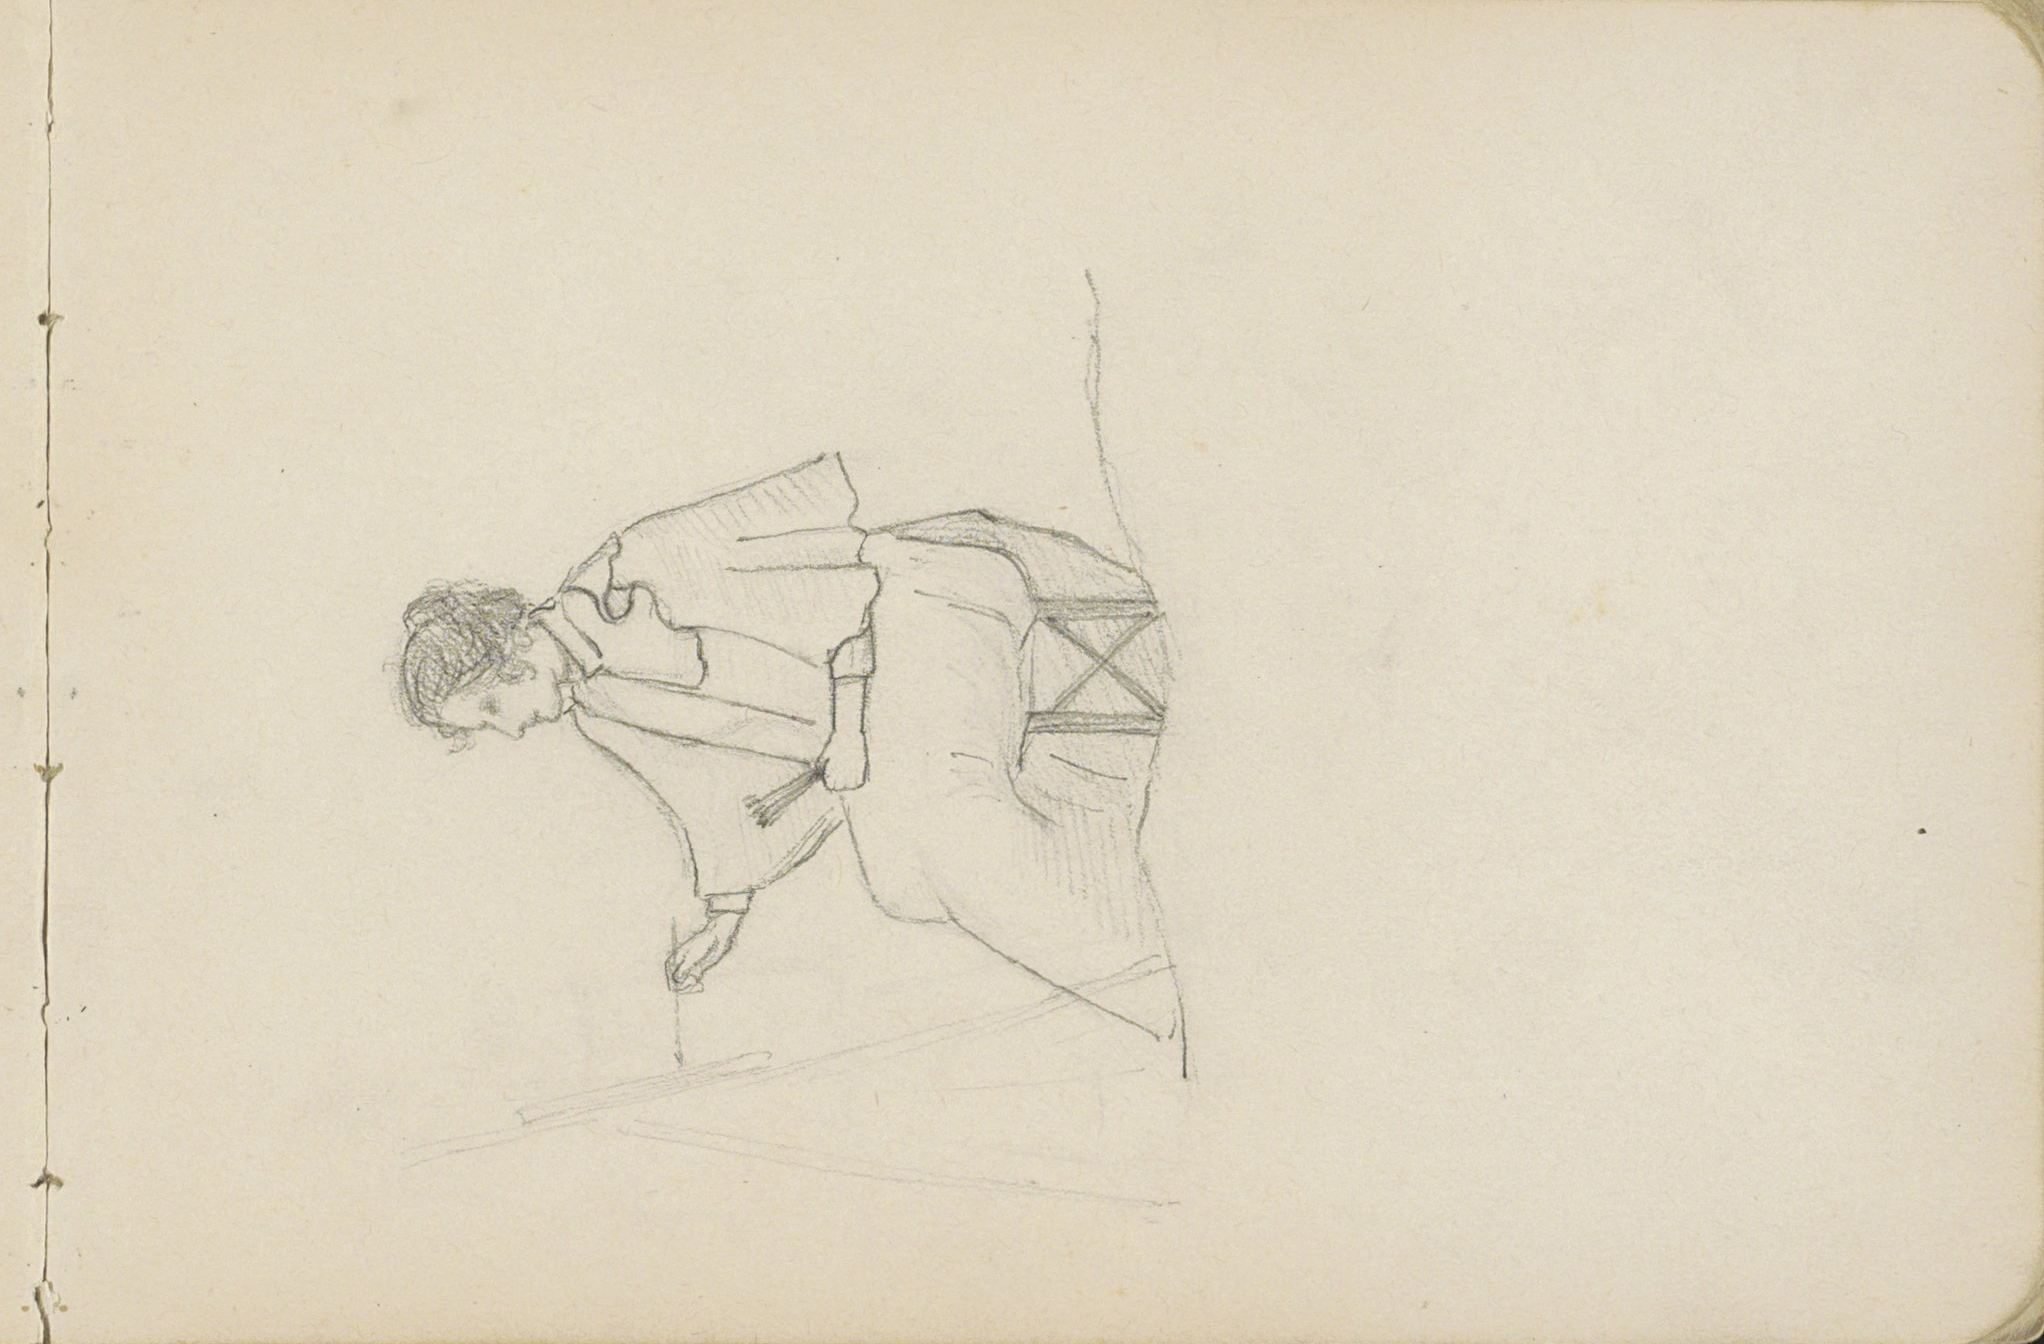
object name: sketchbook leaf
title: Vrouw zittend achter een schildersezel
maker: julie de graag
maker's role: draughtsman, print maker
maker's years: 1877-1924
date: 1894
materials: paper, pencil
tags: adult woman, easel, working situations ~ painter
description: De vrouw zit op een kruk en heeft een bos penselen in de linkerhand. Blad 10 recto uit een schetsboek met 35 bladen.